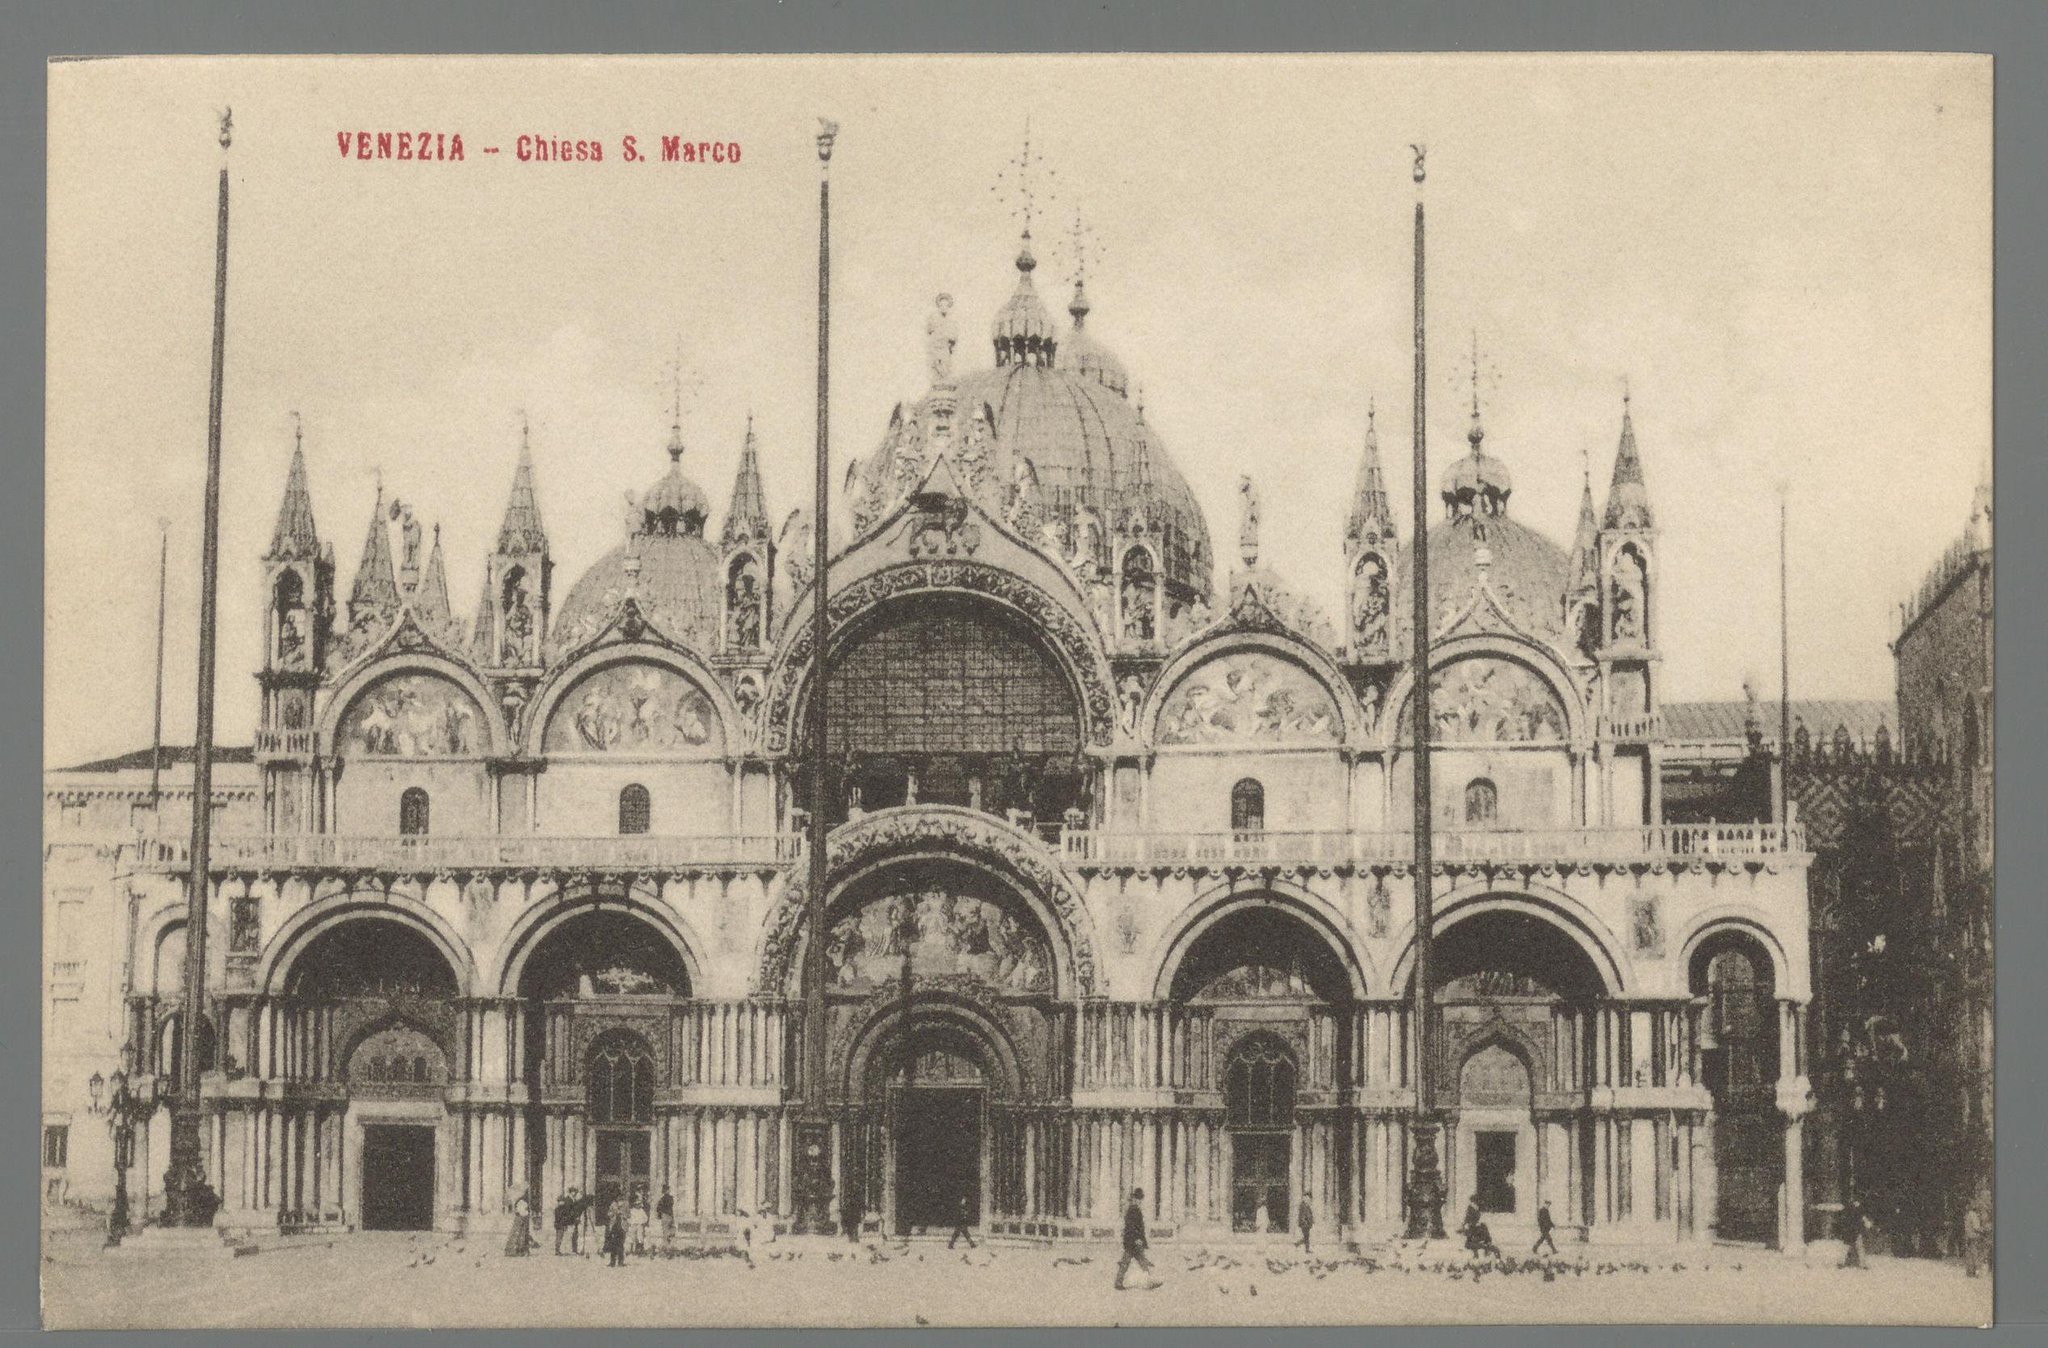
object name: ansichtkaart, prentbriefkaart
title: Venezia. Chiesa S. Marco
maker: Anonymous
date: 1906-1920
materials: cardboard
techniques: photograph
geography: venice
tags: church (exterior), square, place, circus, etc. (+ city(-scape) with figures, staffage)